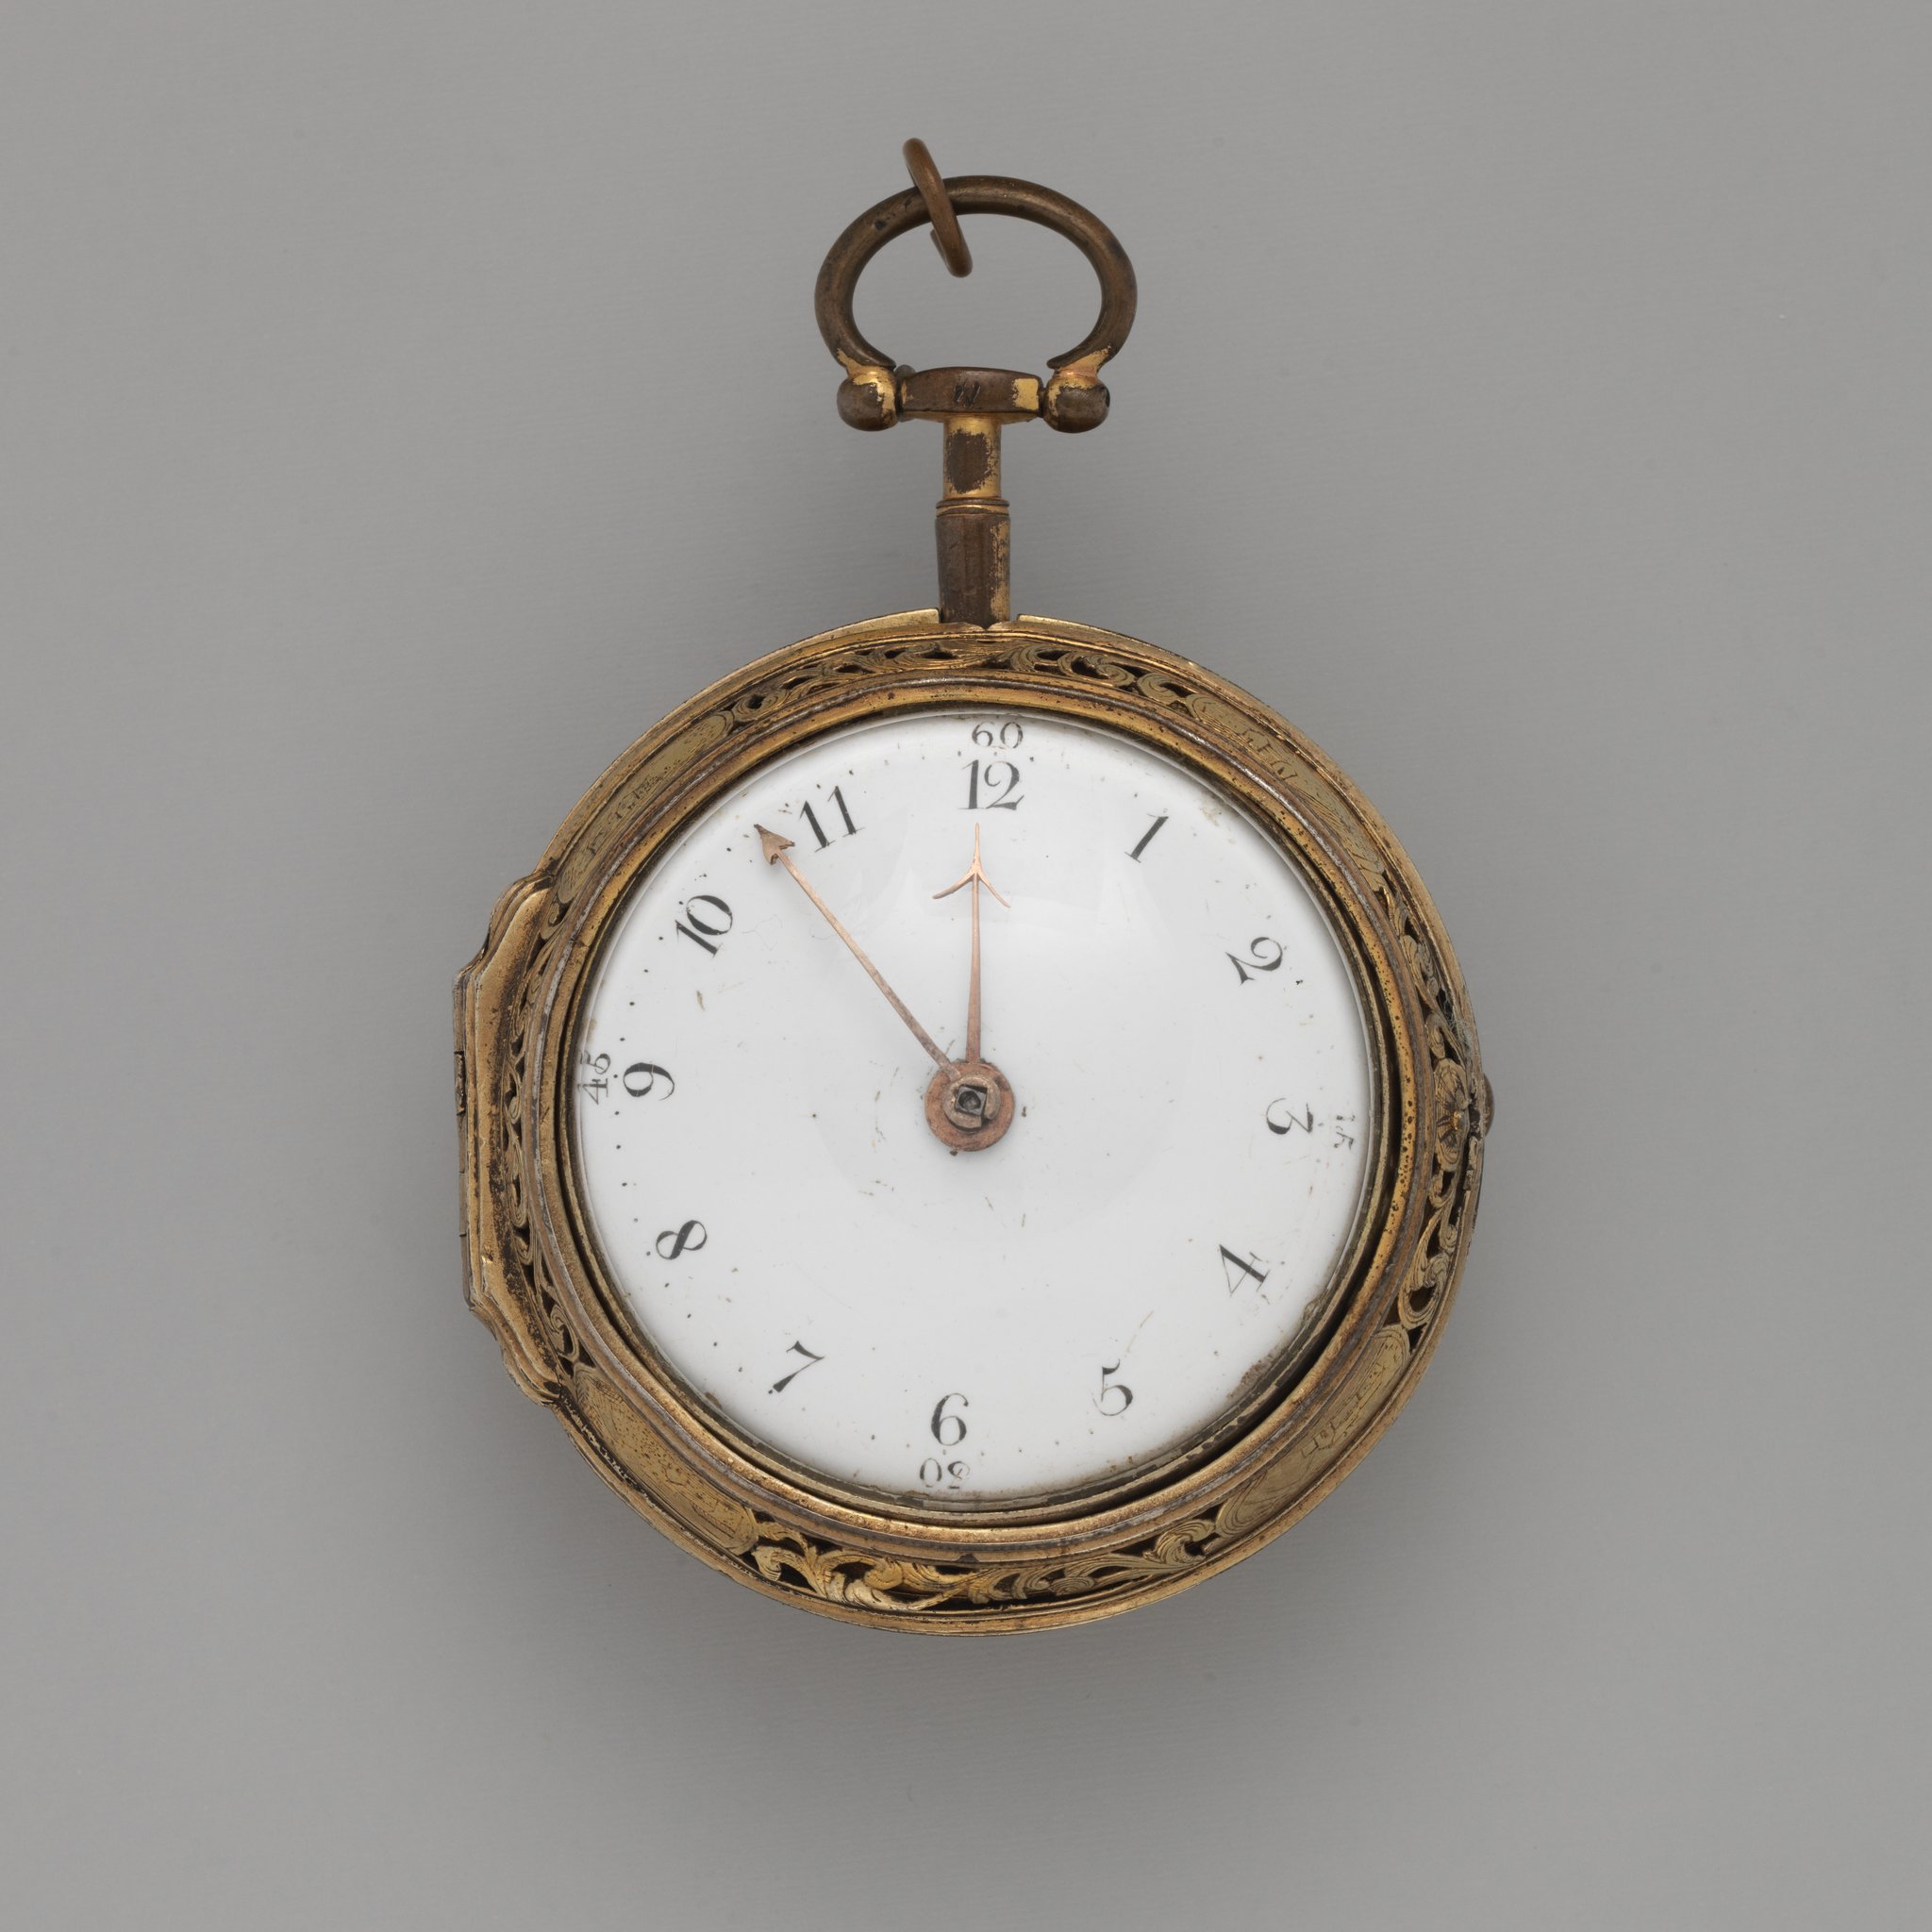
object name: clock watch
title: Clock-watch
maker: daniel le count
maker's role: maker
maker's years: 1676-1693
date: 1667-1700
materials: gilt, metal